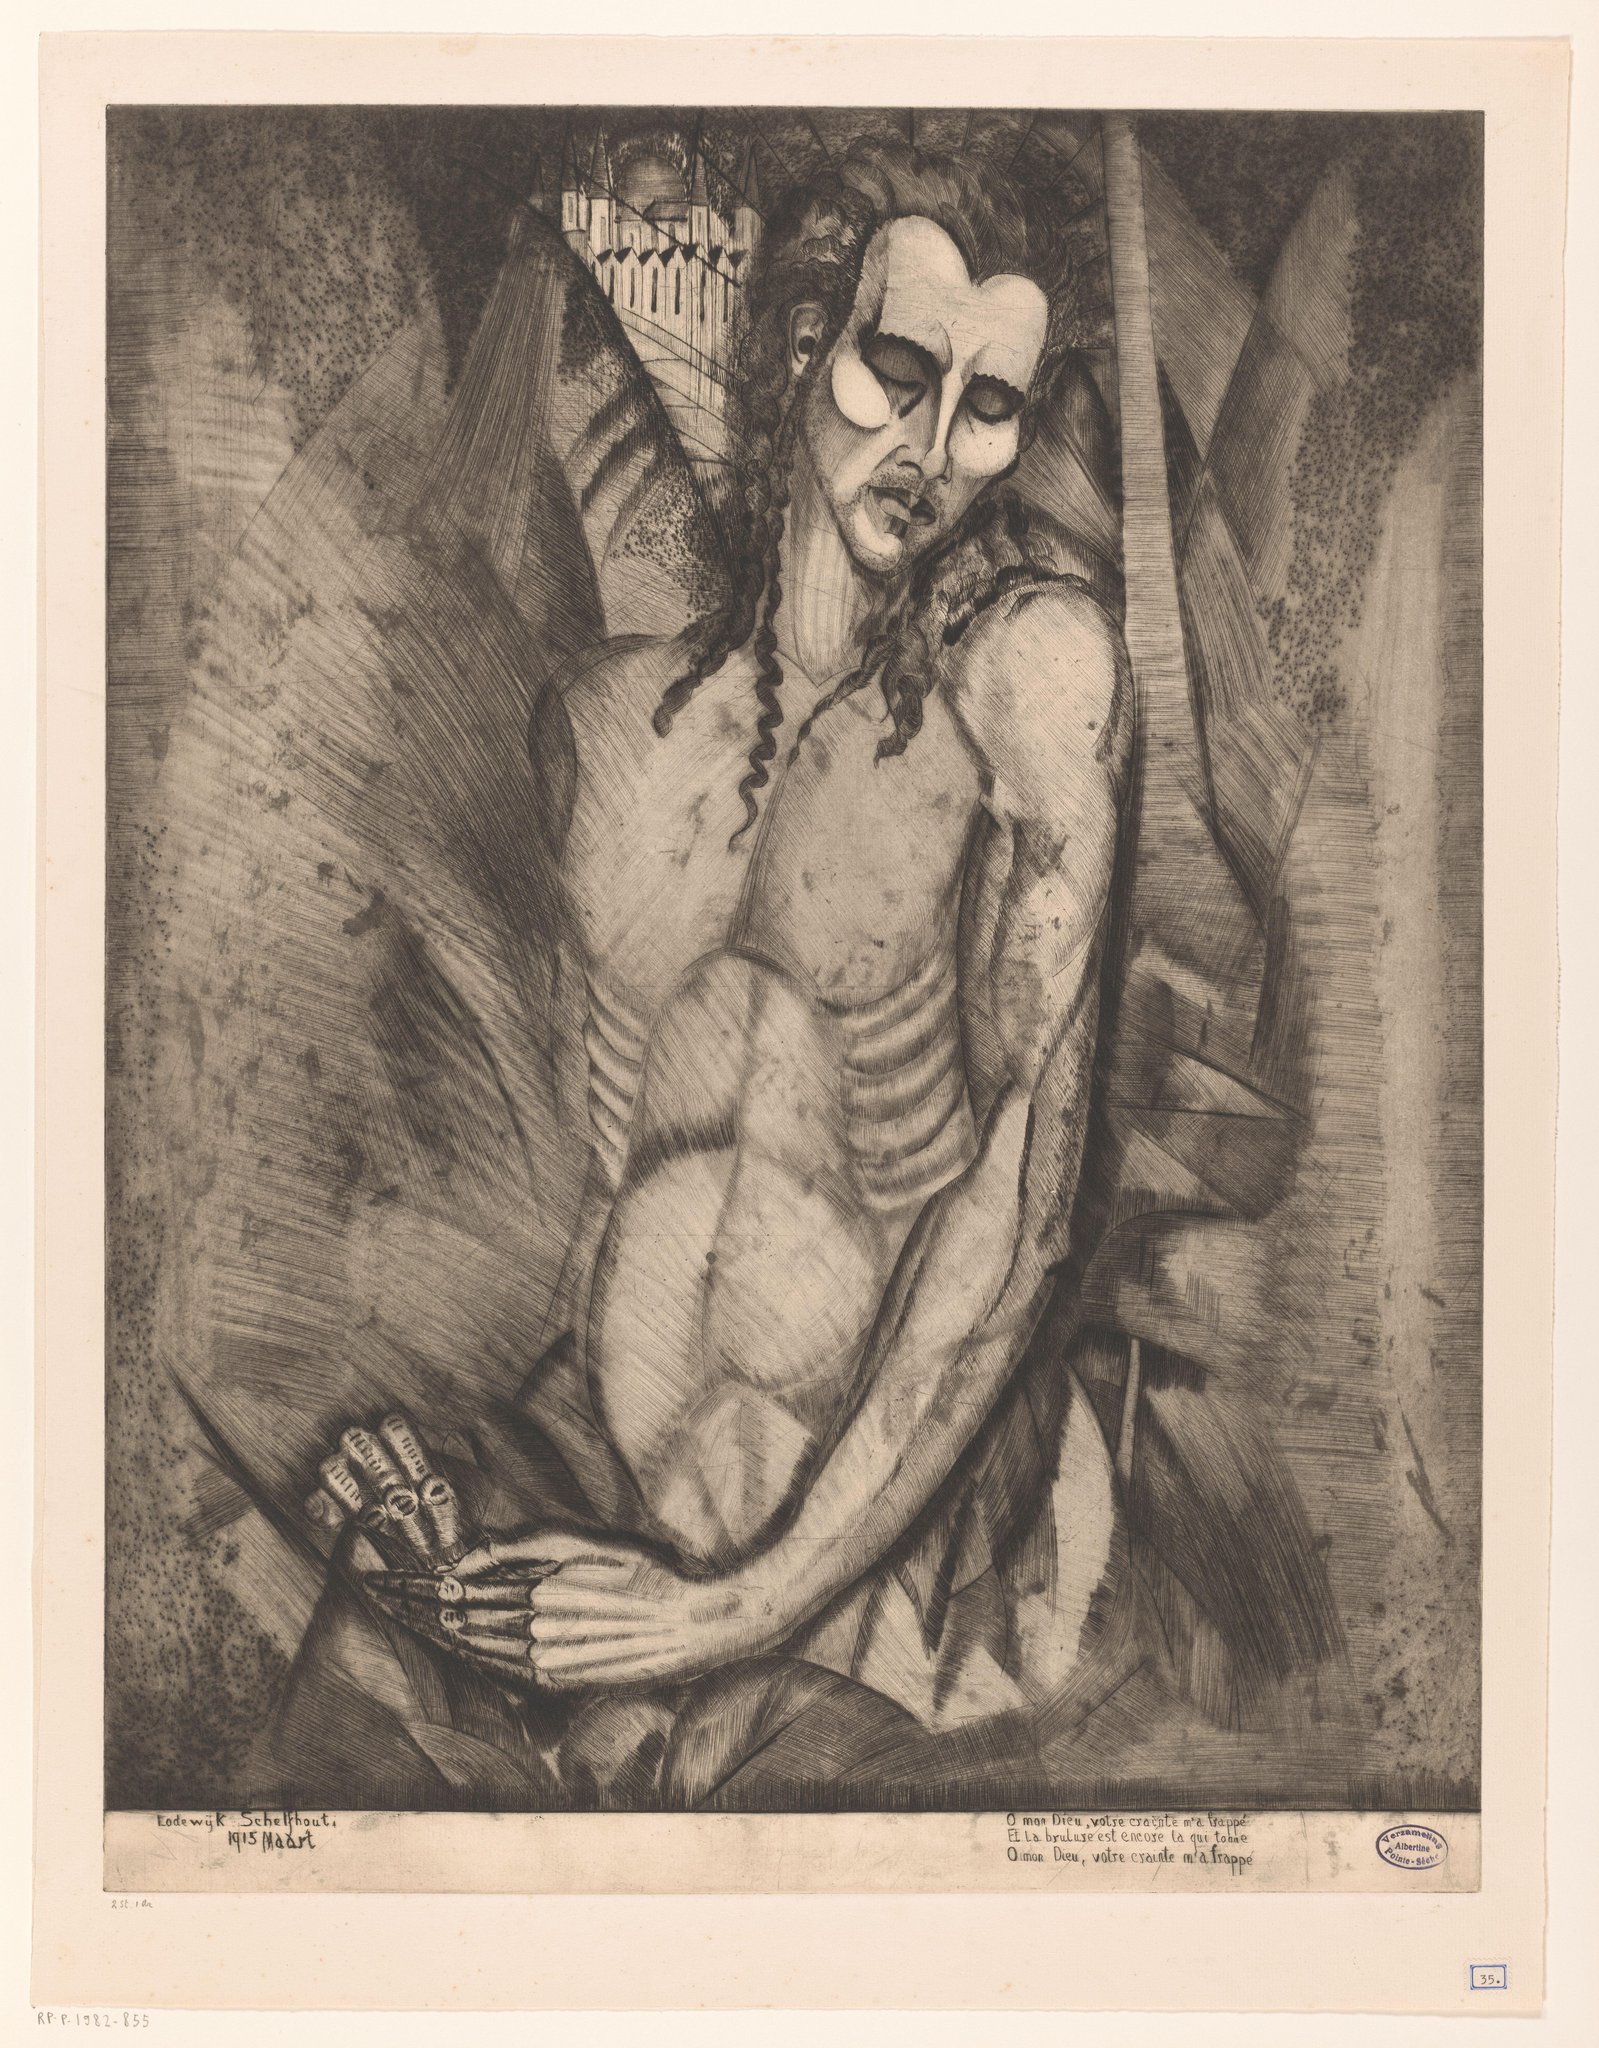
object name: print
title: Le Martyr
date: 1903-1915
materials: paper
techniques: drypoint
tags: paris, paul verlaine, eyes closed, man (showing himself) undressed, quasi-nude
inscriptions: collector's mark: Lugt 2760, collector's mark: Lugt 5i, collector's mark: Lugt 2228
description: Een naakte man met gesloten ogen en haar dat over zijn schouders valt. Op de achtergrond een gebouw met torens. Rechtsonder drie regels uit het gedicht 'O mon Dieu, vous m'avez blessé d'amour' van de Franse dichter Paul Verlaine: 'O mon Dieu, votre crainte m'a frappé / Et la brûlure est encor là qui tonne / O mon Dieu votre crainte m'a frappé'.